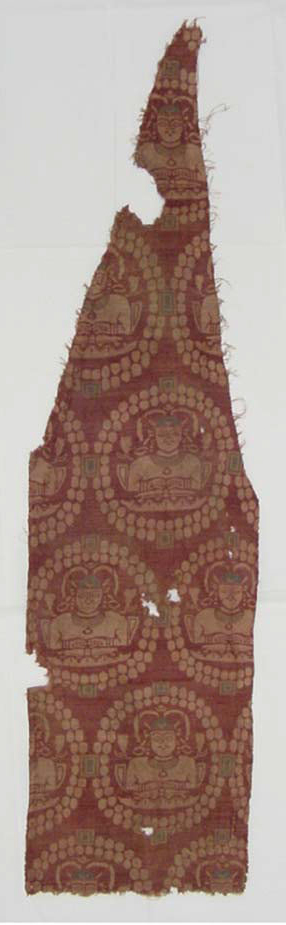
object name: textile fragment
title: Woven Textile with Male Bust in Pearl Roundel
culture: central asian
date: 601-800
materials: silk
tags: men